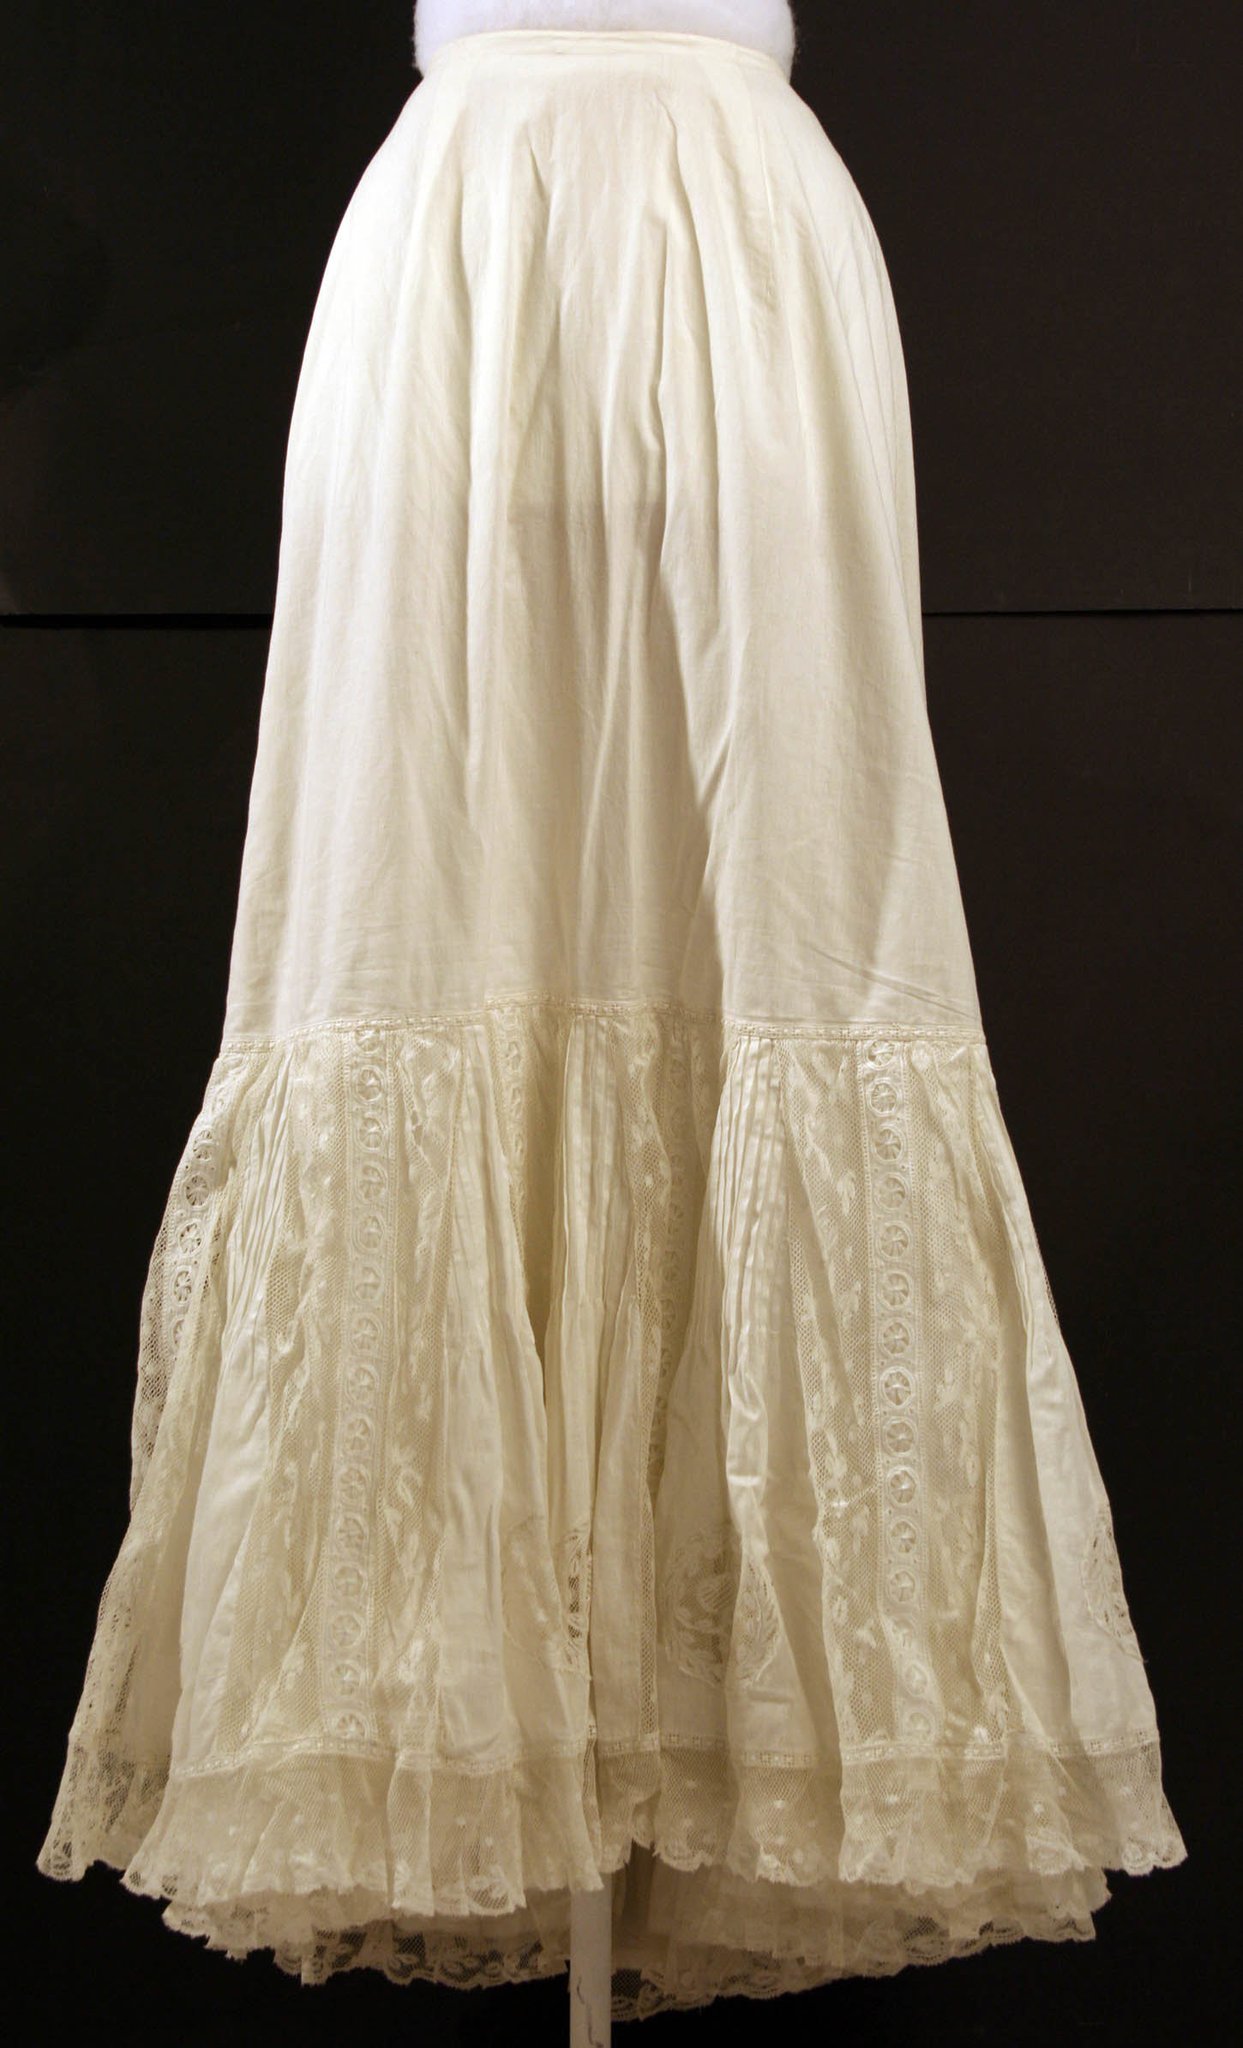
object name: petticoat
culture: american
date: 1867-1933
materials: cotton